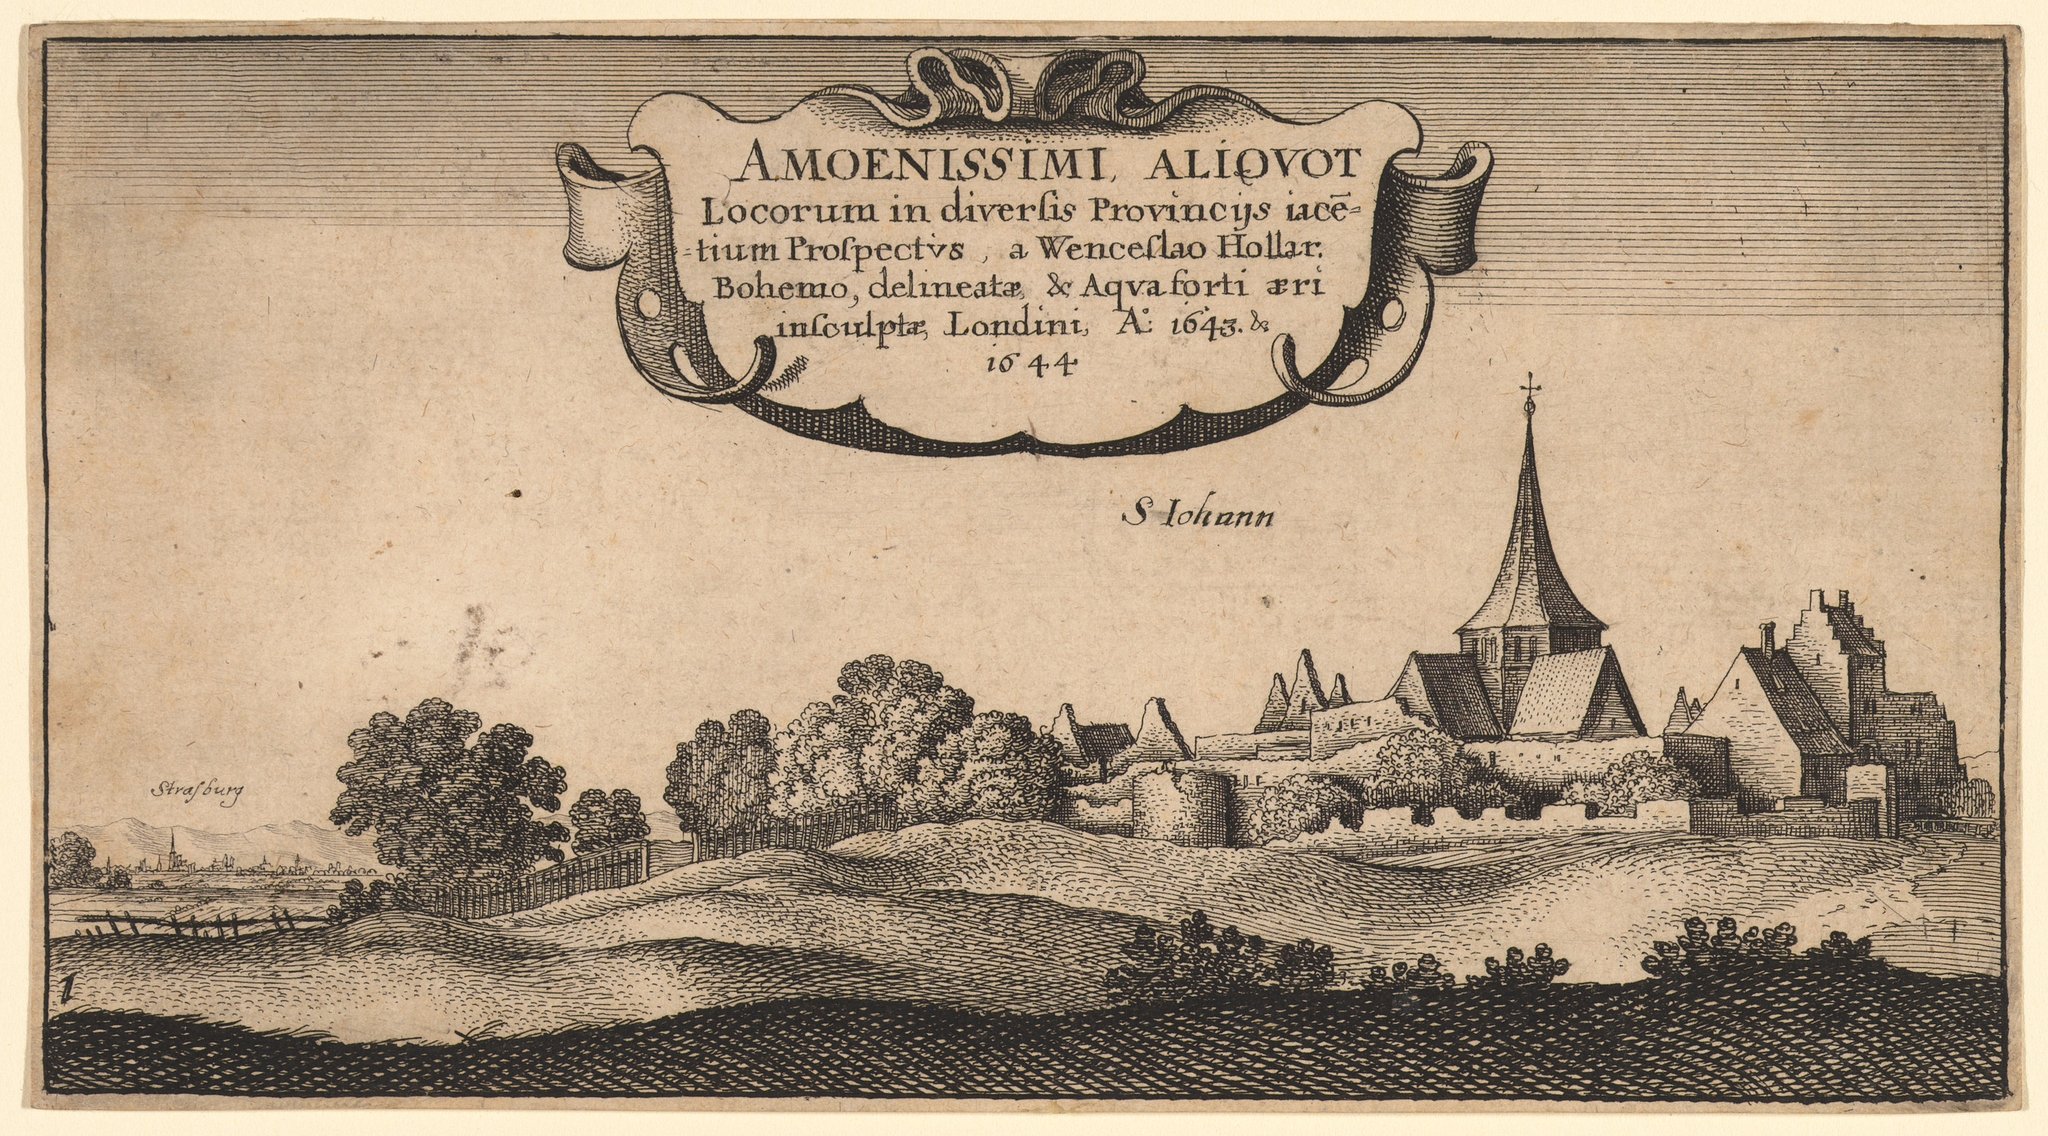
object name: print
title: Title page to "Amoenissimi Aliquot Locorum in divertis Provincys"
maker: wenceslaus hollar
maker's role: artist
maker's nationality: bohemian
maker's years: 1607-1677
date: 1643-1644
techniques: etching